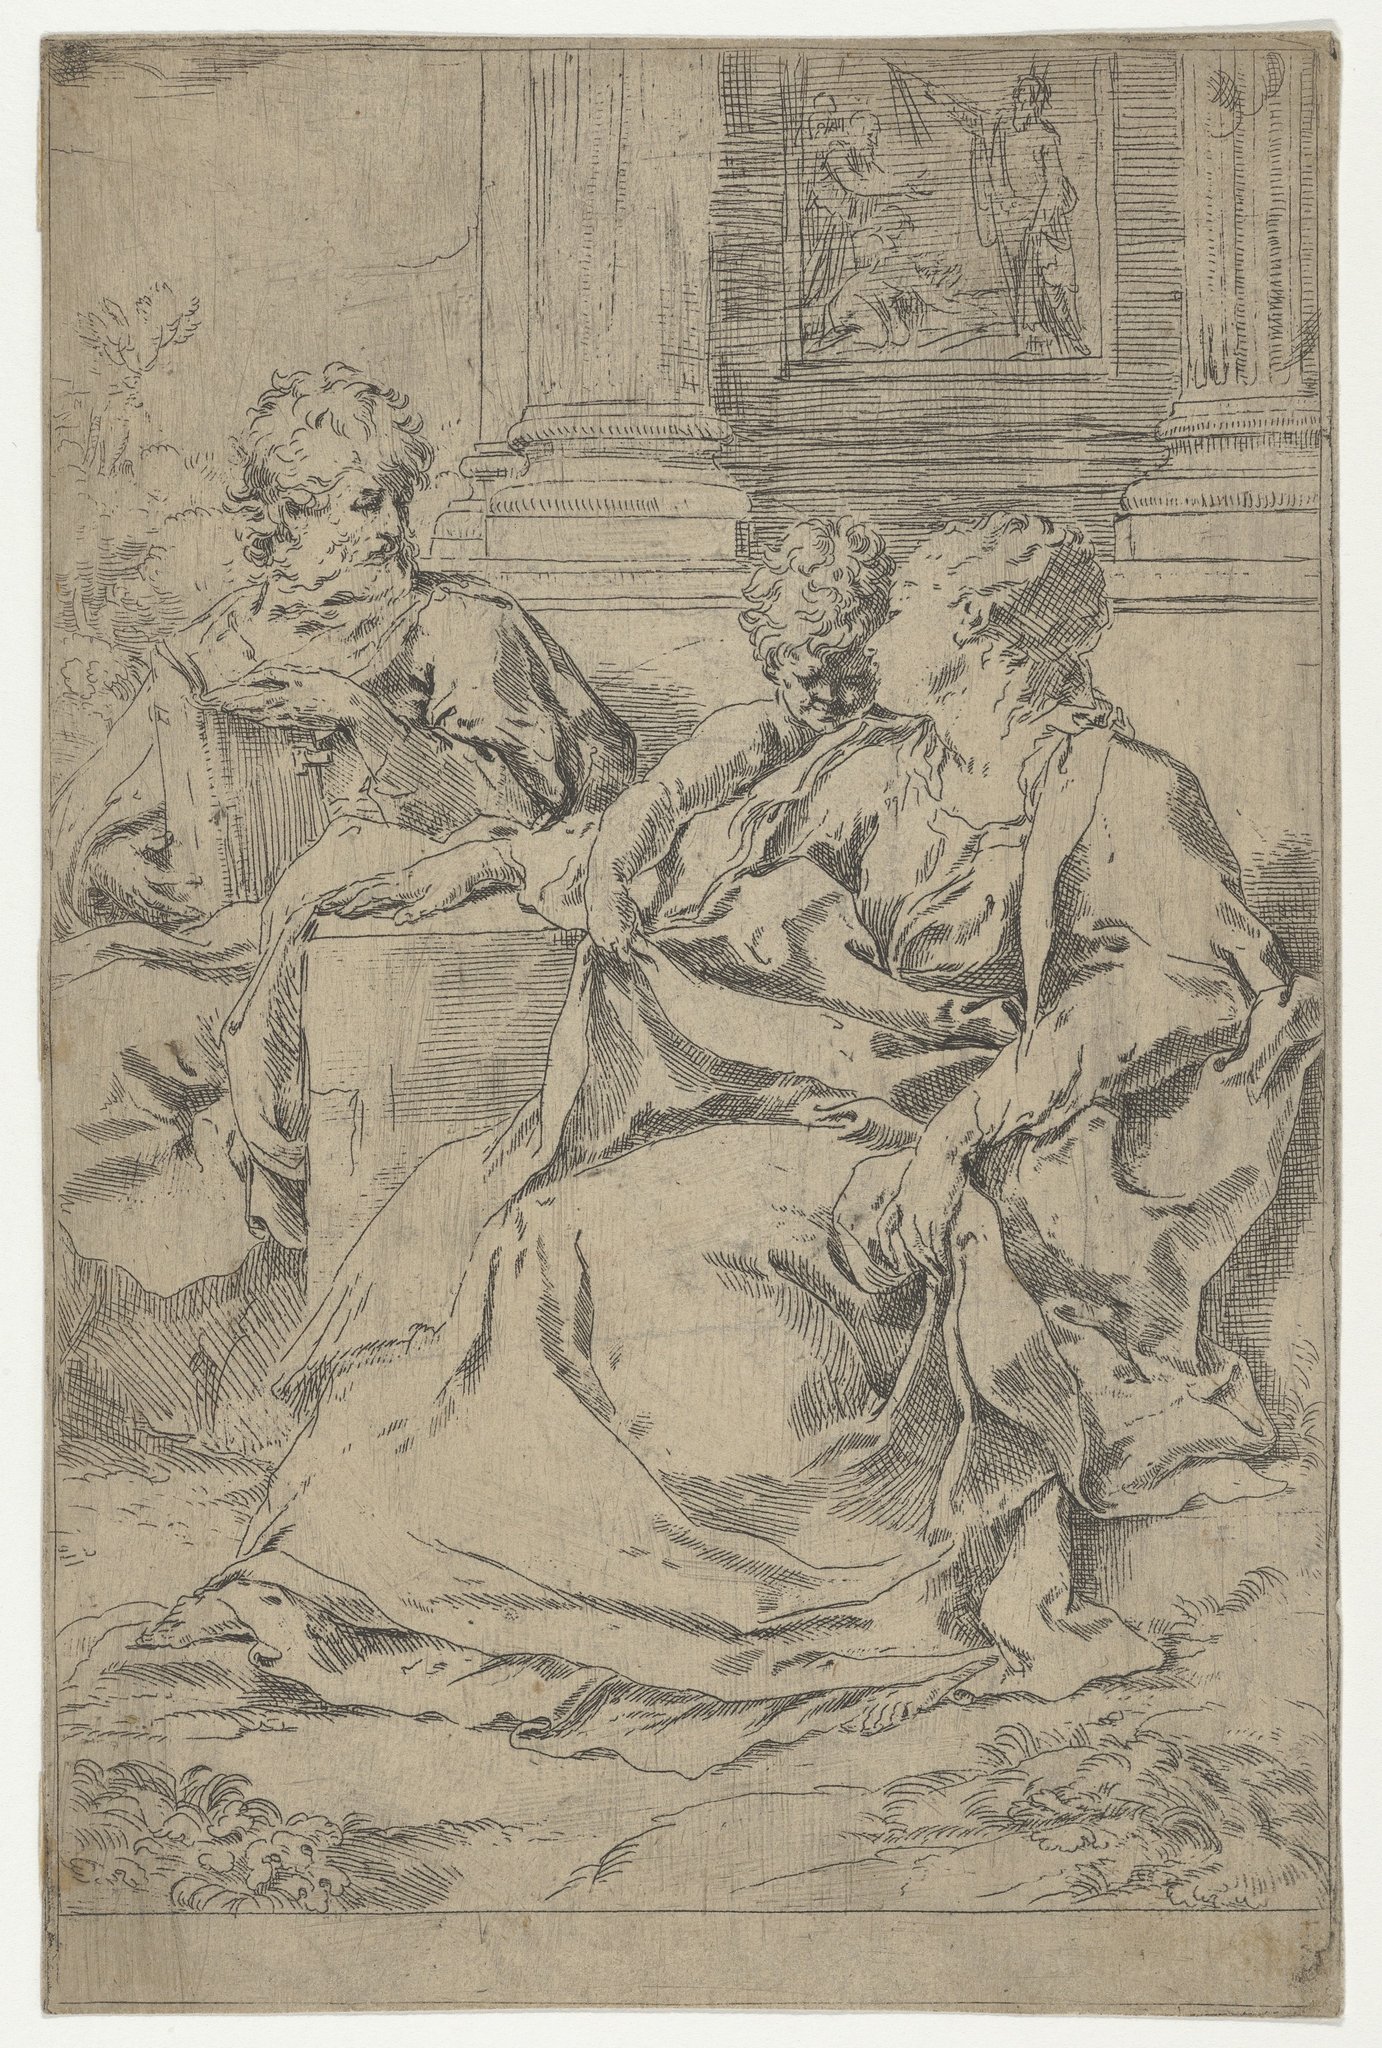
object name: print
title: The Holy Family seated together in front of a collonade, Saint Joseph reading and the young Christ grasping the Virgin's drapery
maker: guido reni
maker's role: artist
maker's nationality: italian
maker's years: 1575-1642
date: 1590-1610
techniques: etching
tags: reading,holy family,saints